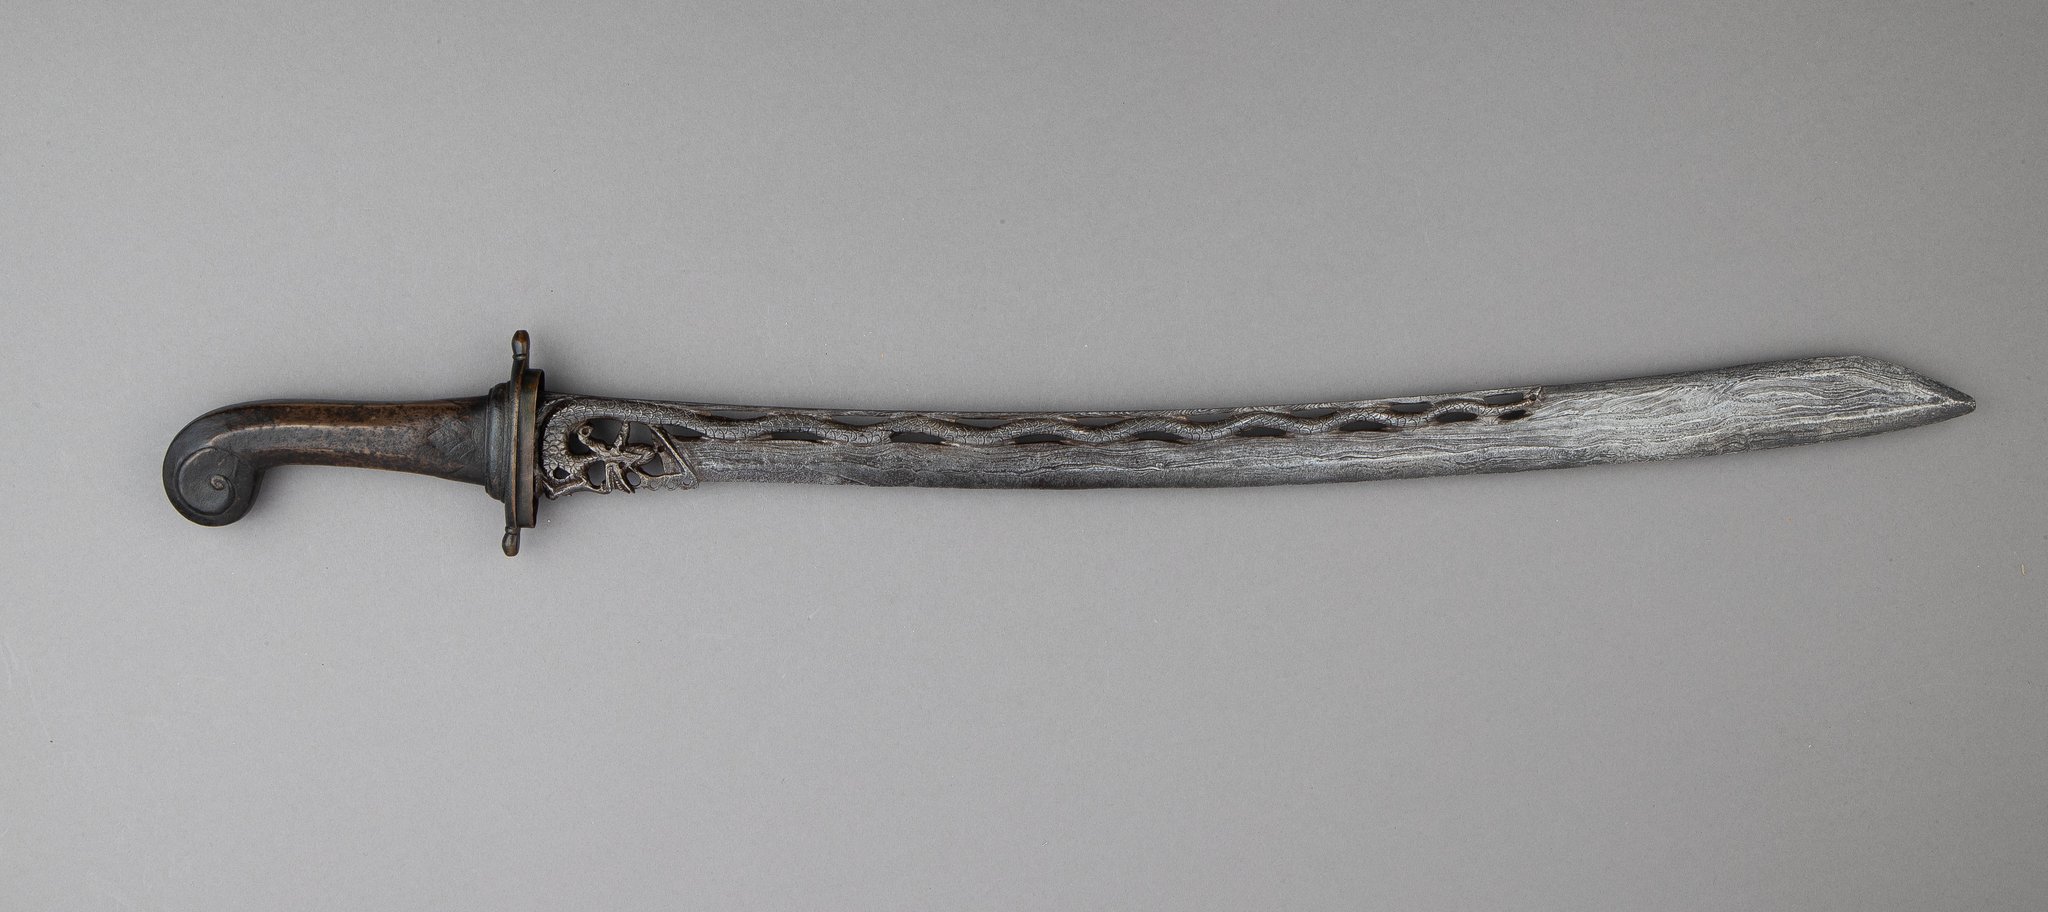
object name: saber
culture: javanese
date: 1501-1900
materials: steel, wood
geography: indonesia